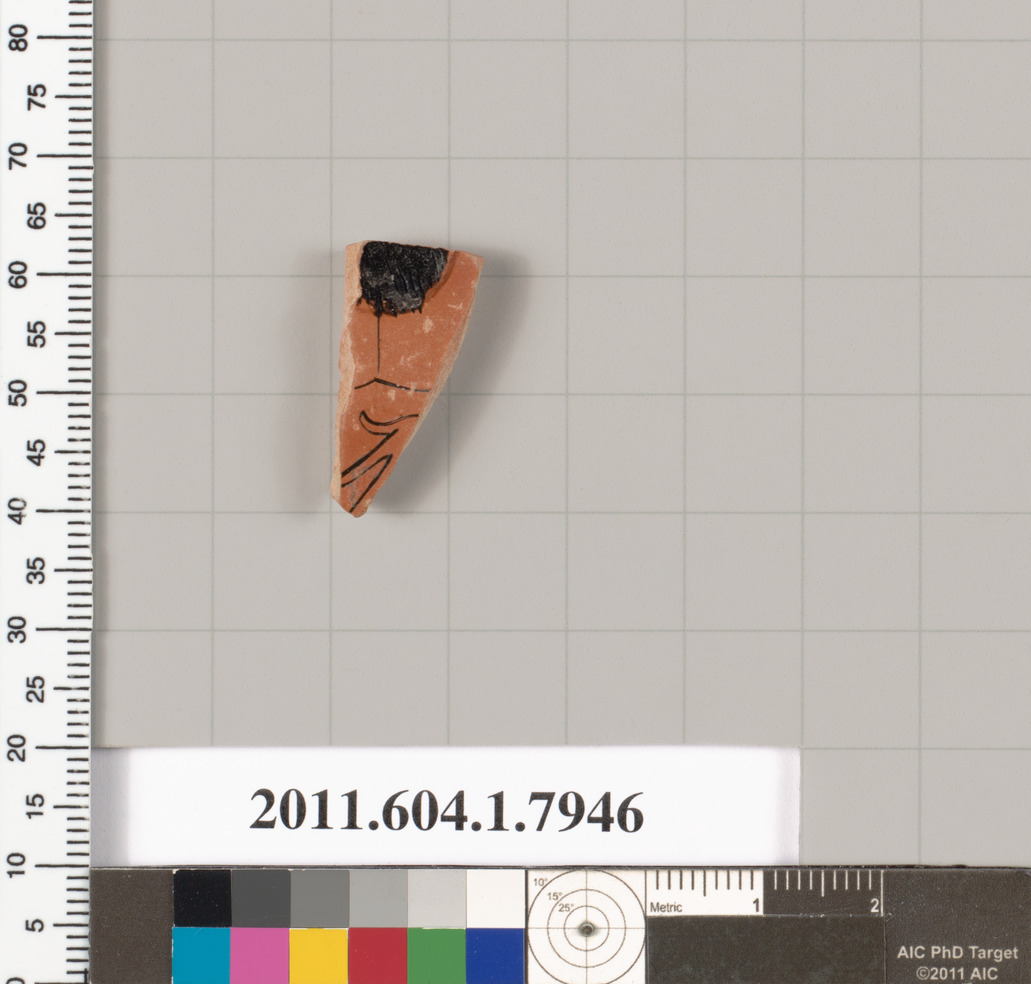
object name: kylix fragment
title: Terracotta fragment of a kylix (drinking cup)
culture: greek, attic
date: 460-450 BCE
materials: terracotta